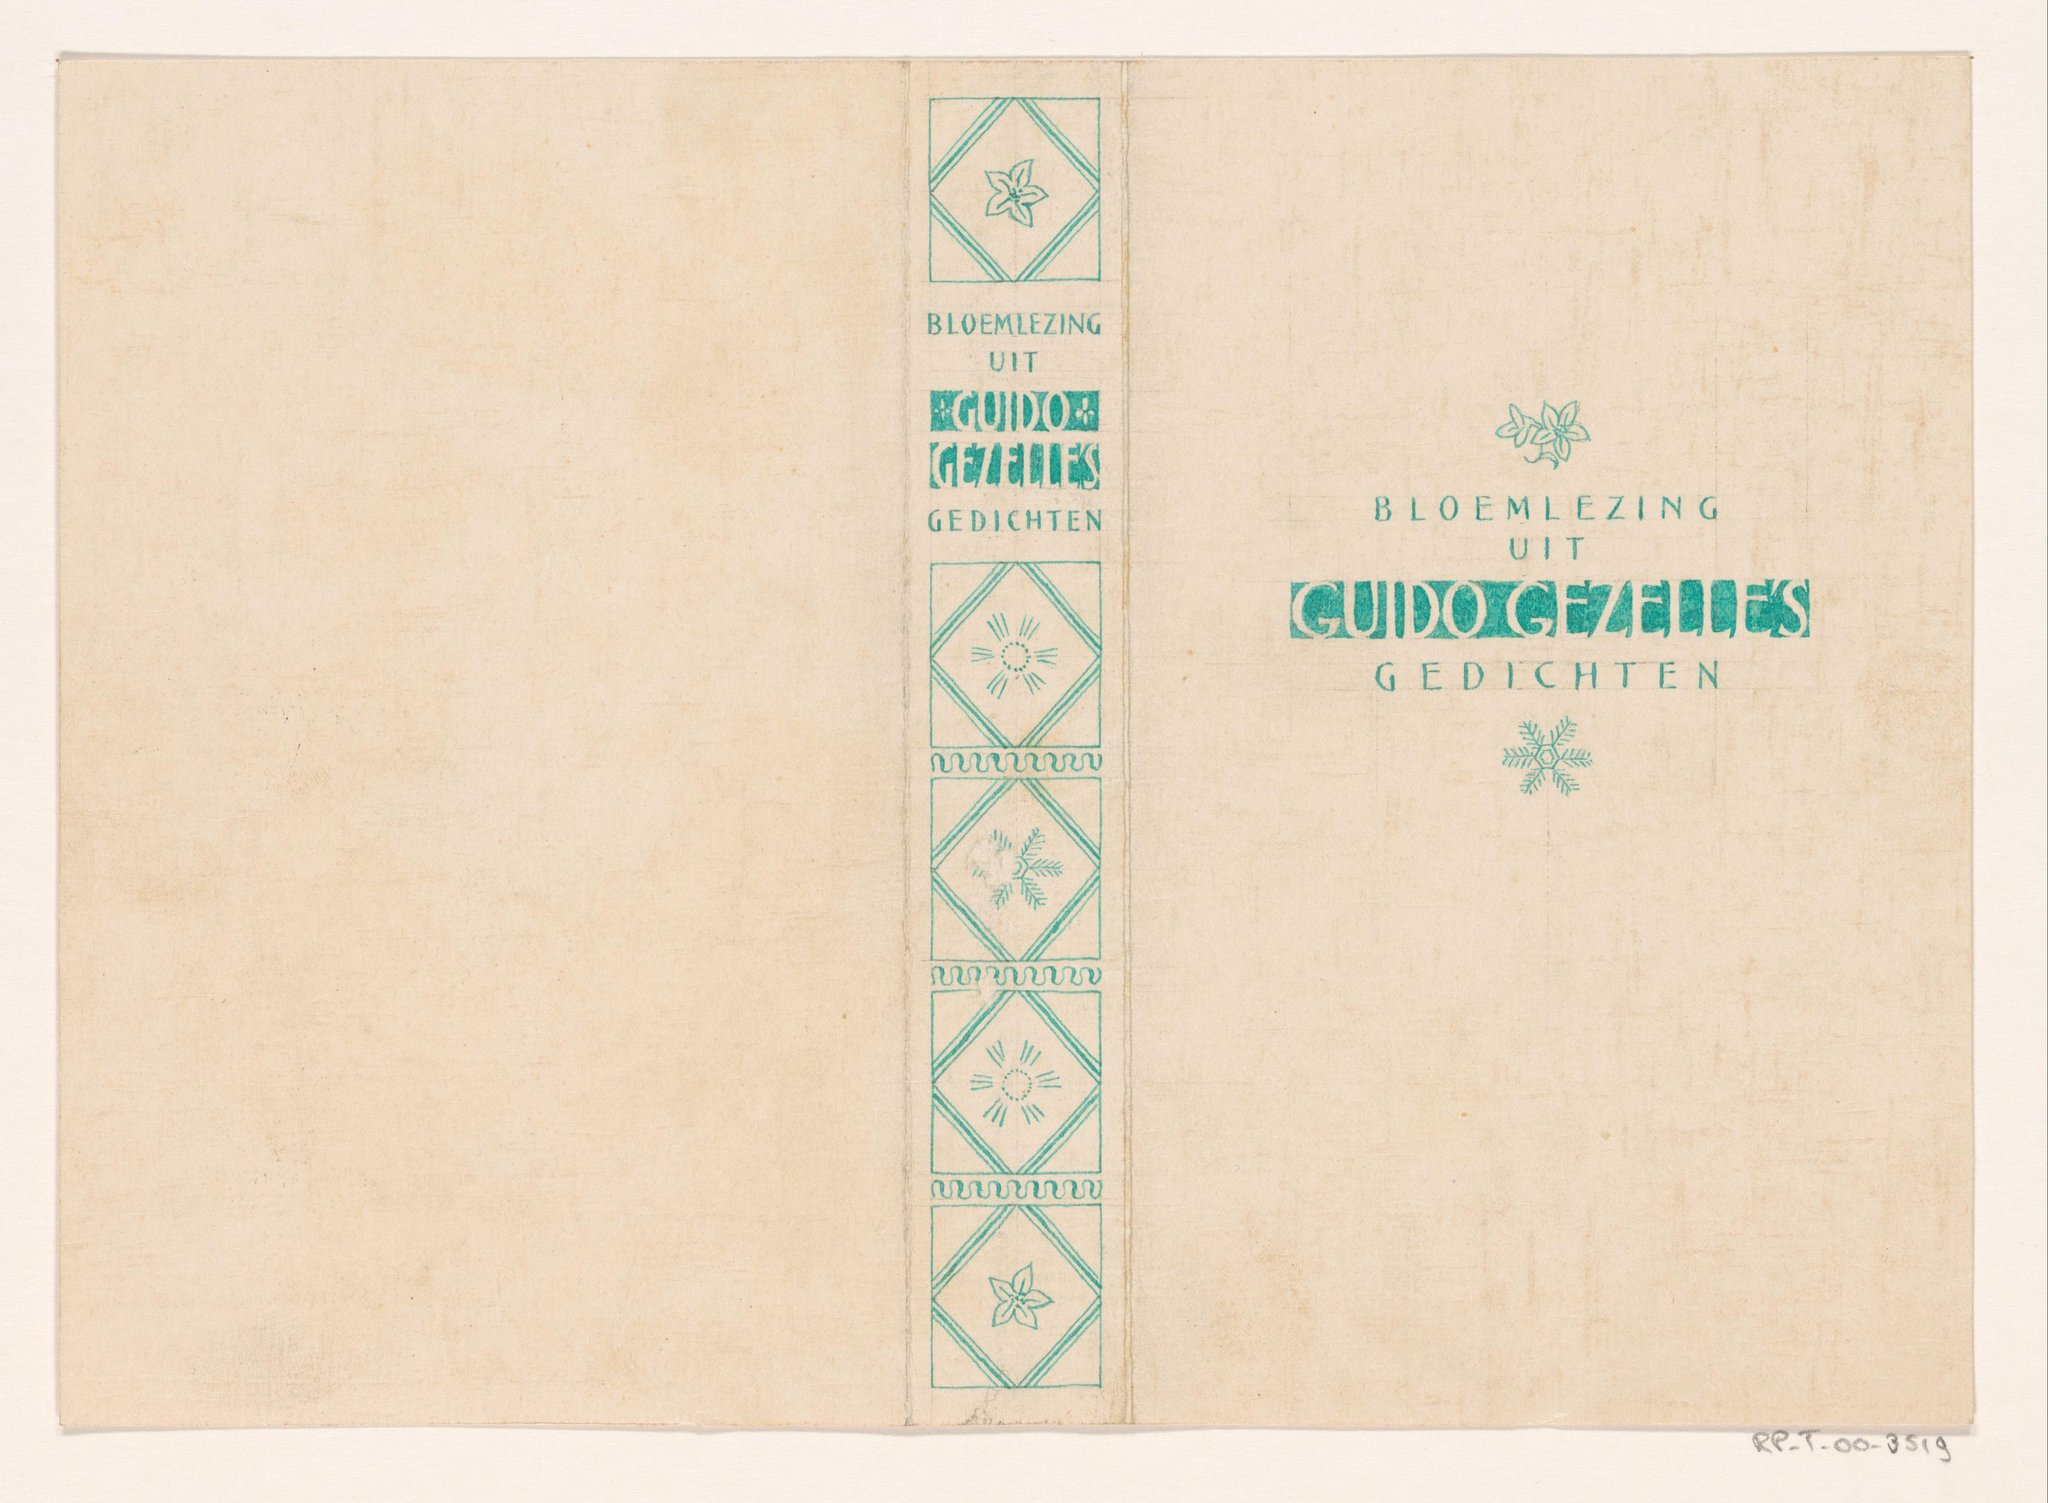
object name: study for binding design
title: Bandontwerp voor: J. Aleida Nijland, Bloemlezing uit Guido Gezelle's gedichten, c. 1904-1940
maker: Anonymous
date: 1904-1940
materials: ink, paper, pencil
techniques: brush, pen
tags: ornament derived from plant forms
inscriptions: collector's mark: Lugt 2228a